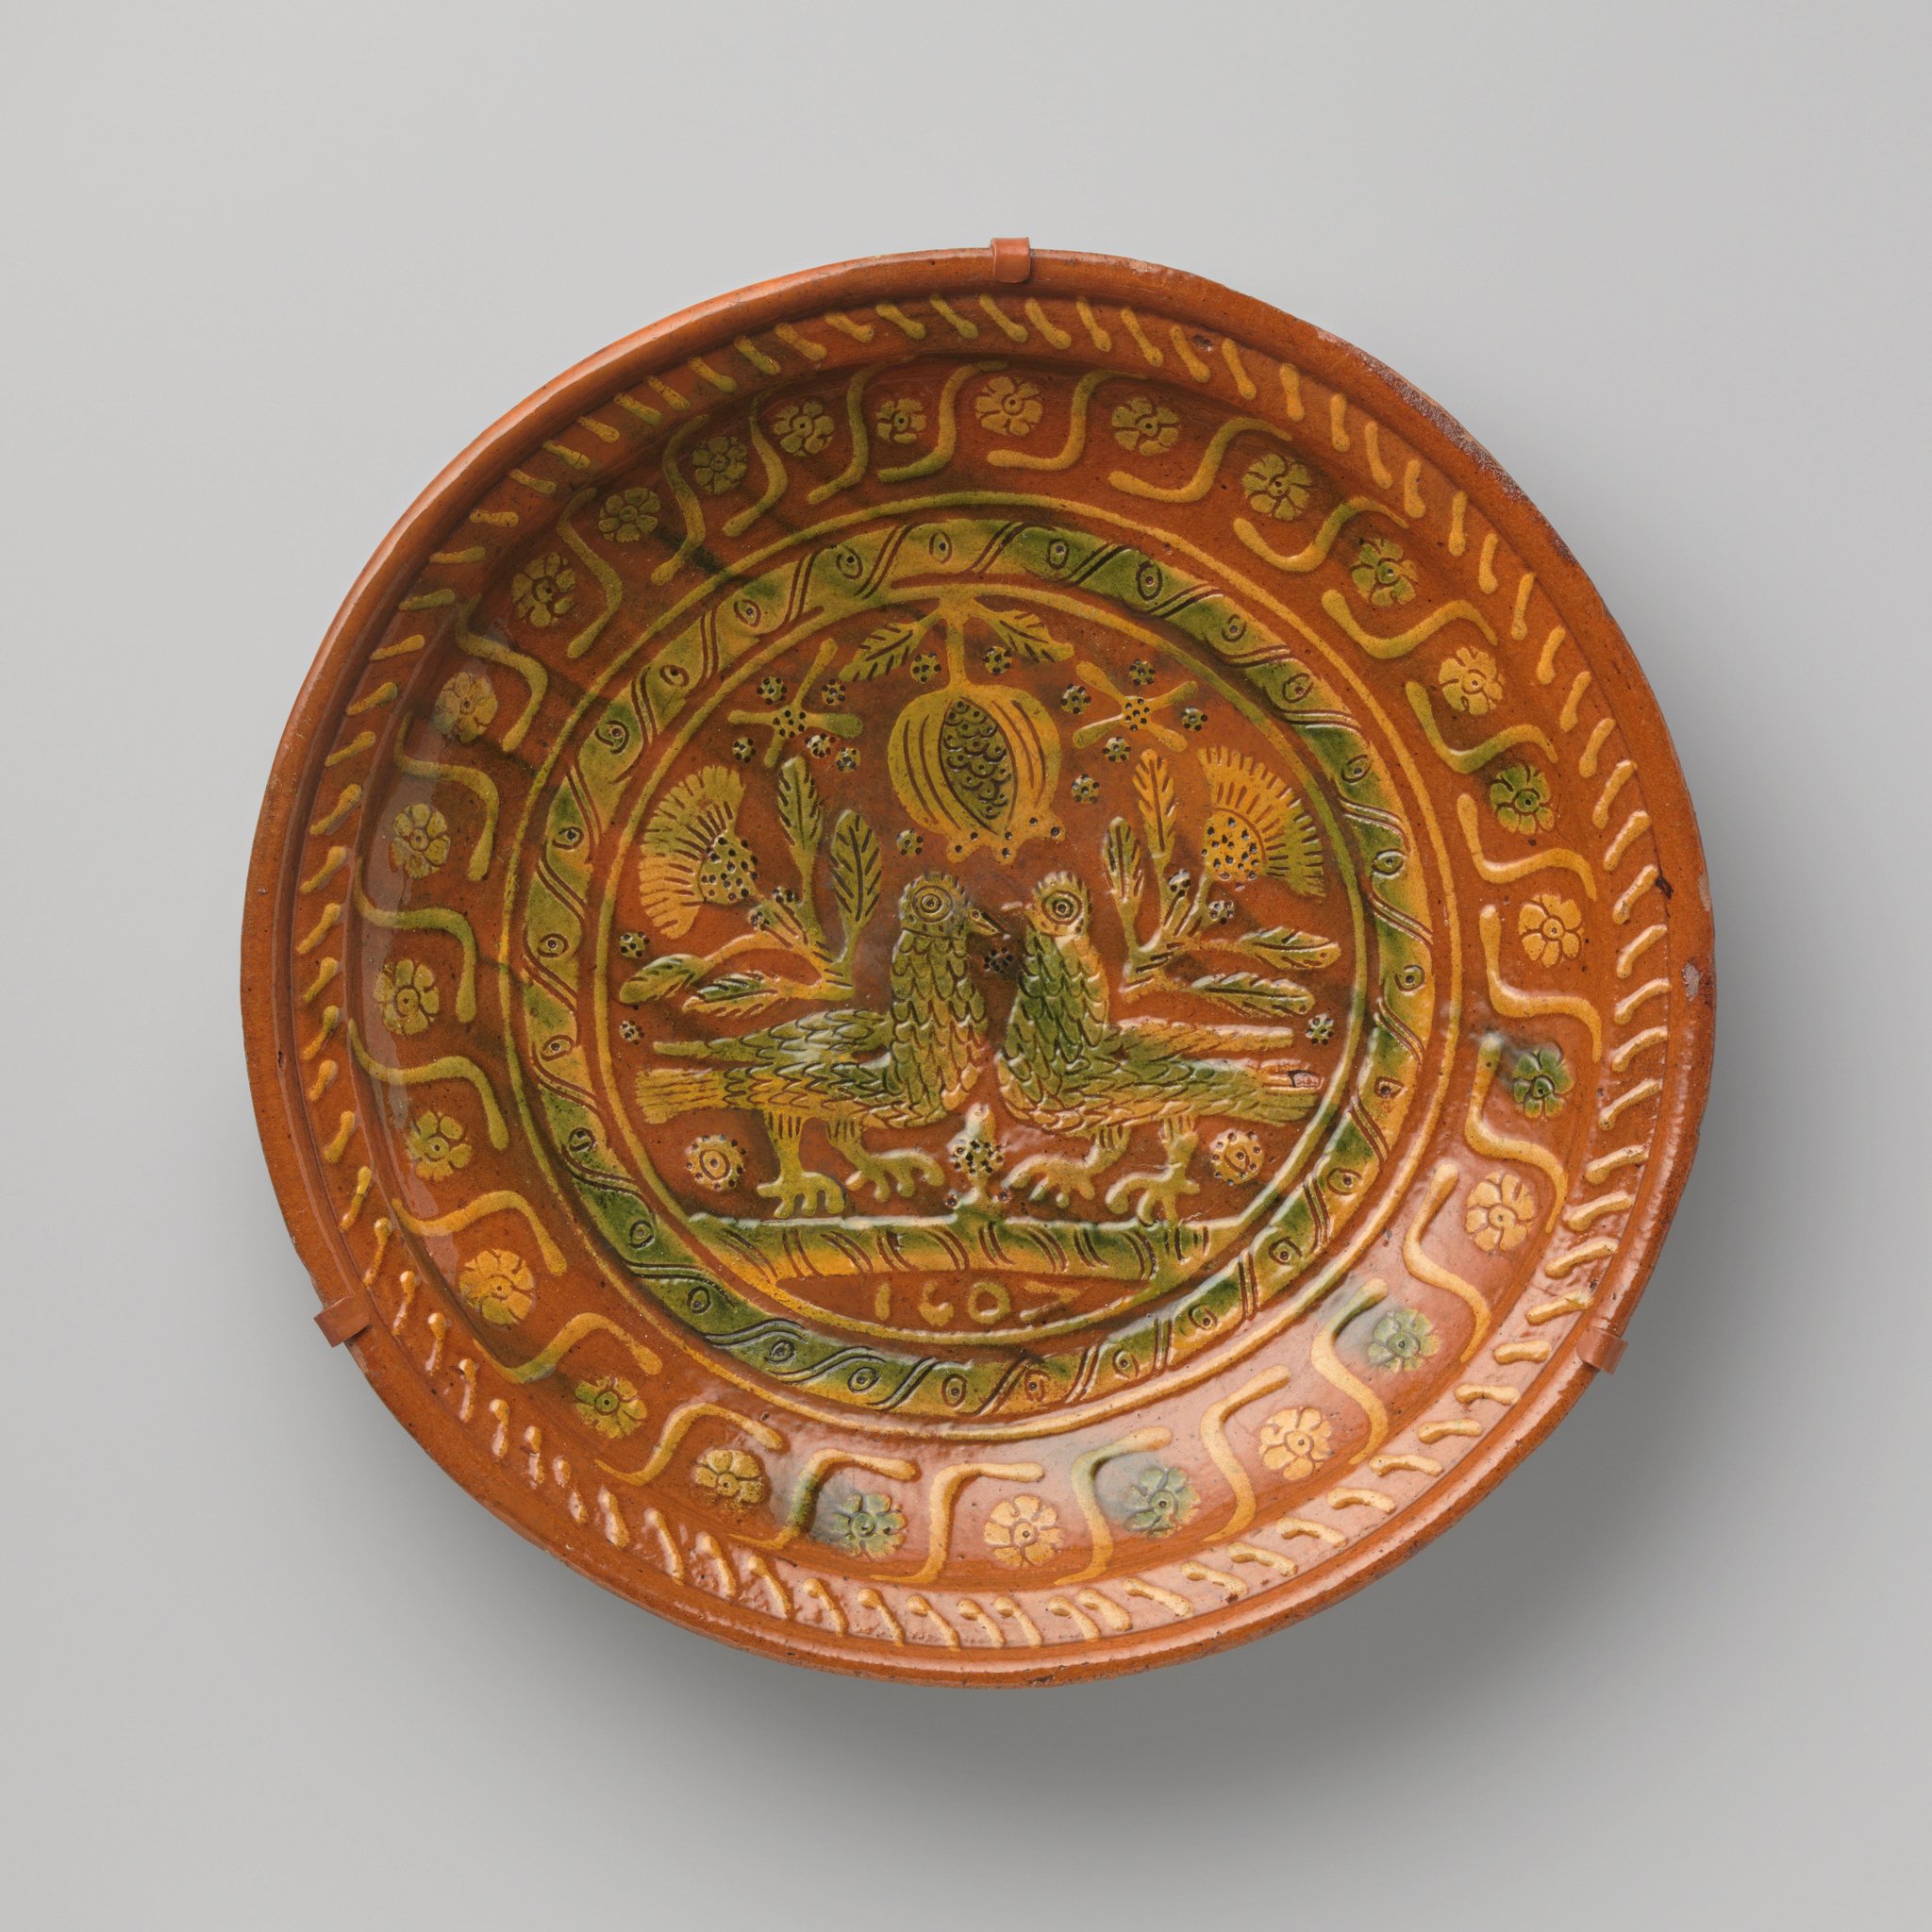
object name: platter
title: Schotel met twee vogels en het jaartal 1607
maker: Anonymous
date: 1607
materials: earthenware, glaze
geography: netherlands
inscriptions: date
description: Ronde schotel van loodglazuuraardewerk, op drie schelpvormige poten. De schotel is in witte slib gedecoreerd, met op het plat twee naar elkaar toegewende gelijke vogels. Onder de vogels is een boomtak geschilderd waaronder het jaartal 1607. Boven de vogels is een hangende granaatappel met links en rechts een bloementak met bladeren geschilderd. Op de rand zijn rozetten afgewisseld door s-vormige motieven geschilderd. De schotel is bedekt met plaatselijk groen getinte loodglazuur.